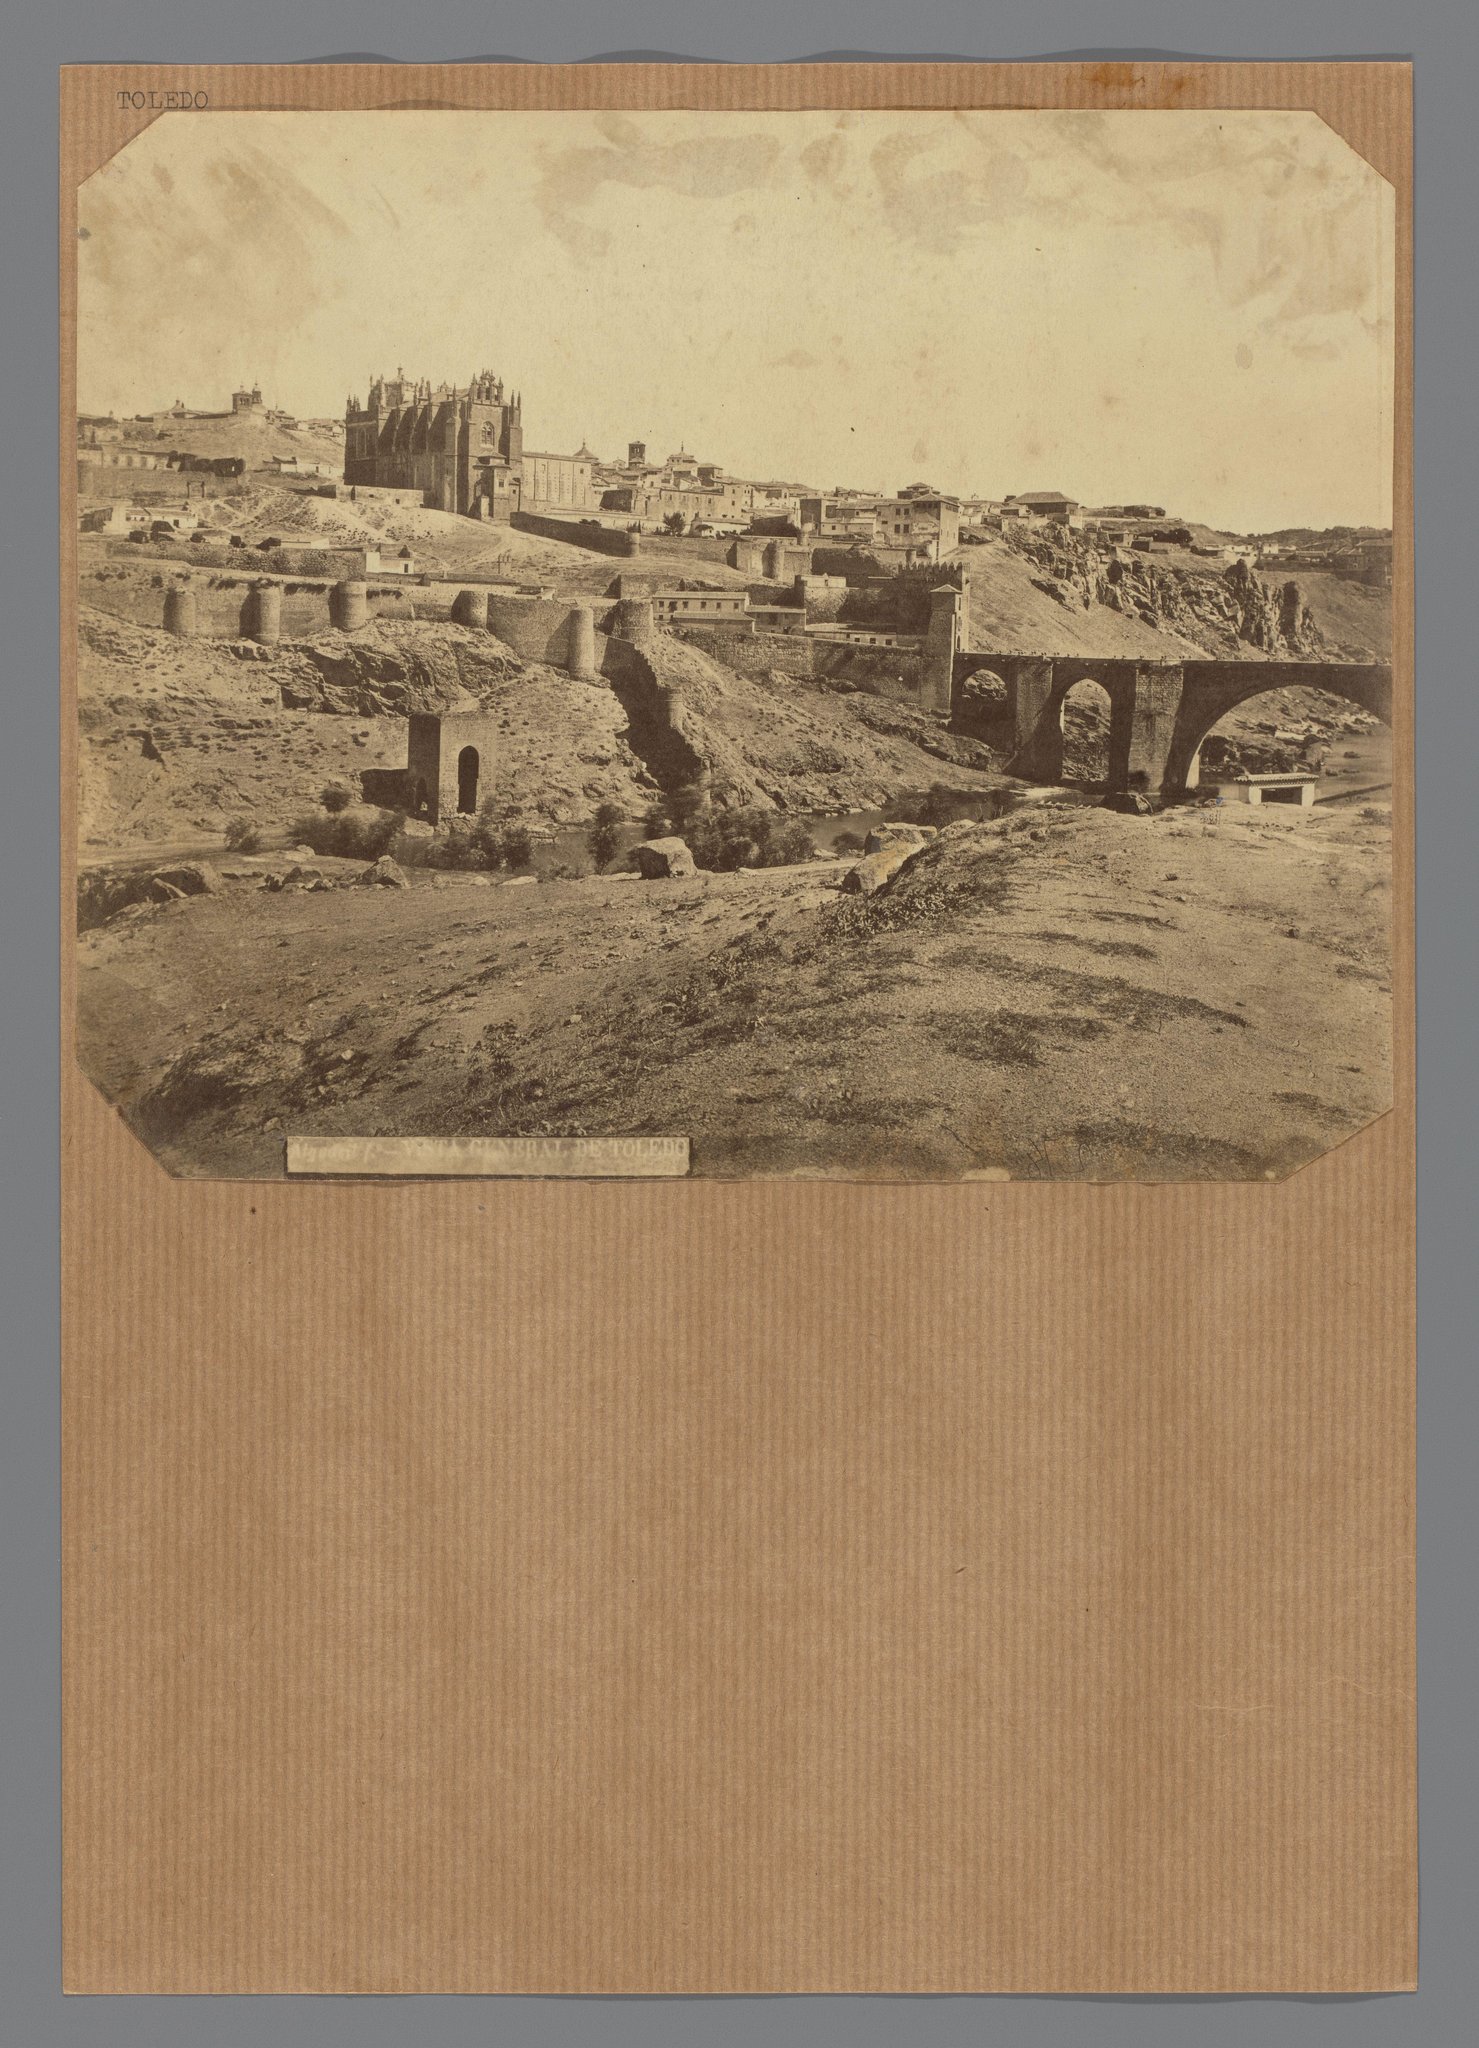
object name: photograph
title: Toledo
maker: Anonymous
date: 1850-1899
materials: paper, photographic support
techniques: albumen print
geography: spain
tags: toledo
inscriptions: stamp: ‘UNIVERSITEIT VAN AMSTERDAM / KUNST / HISTORISCH / INSTITUUT’, inscription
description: Foto uit de studiecollectie van het Kunsthistorisch Instituut van de Universiteit van Amsterdam.